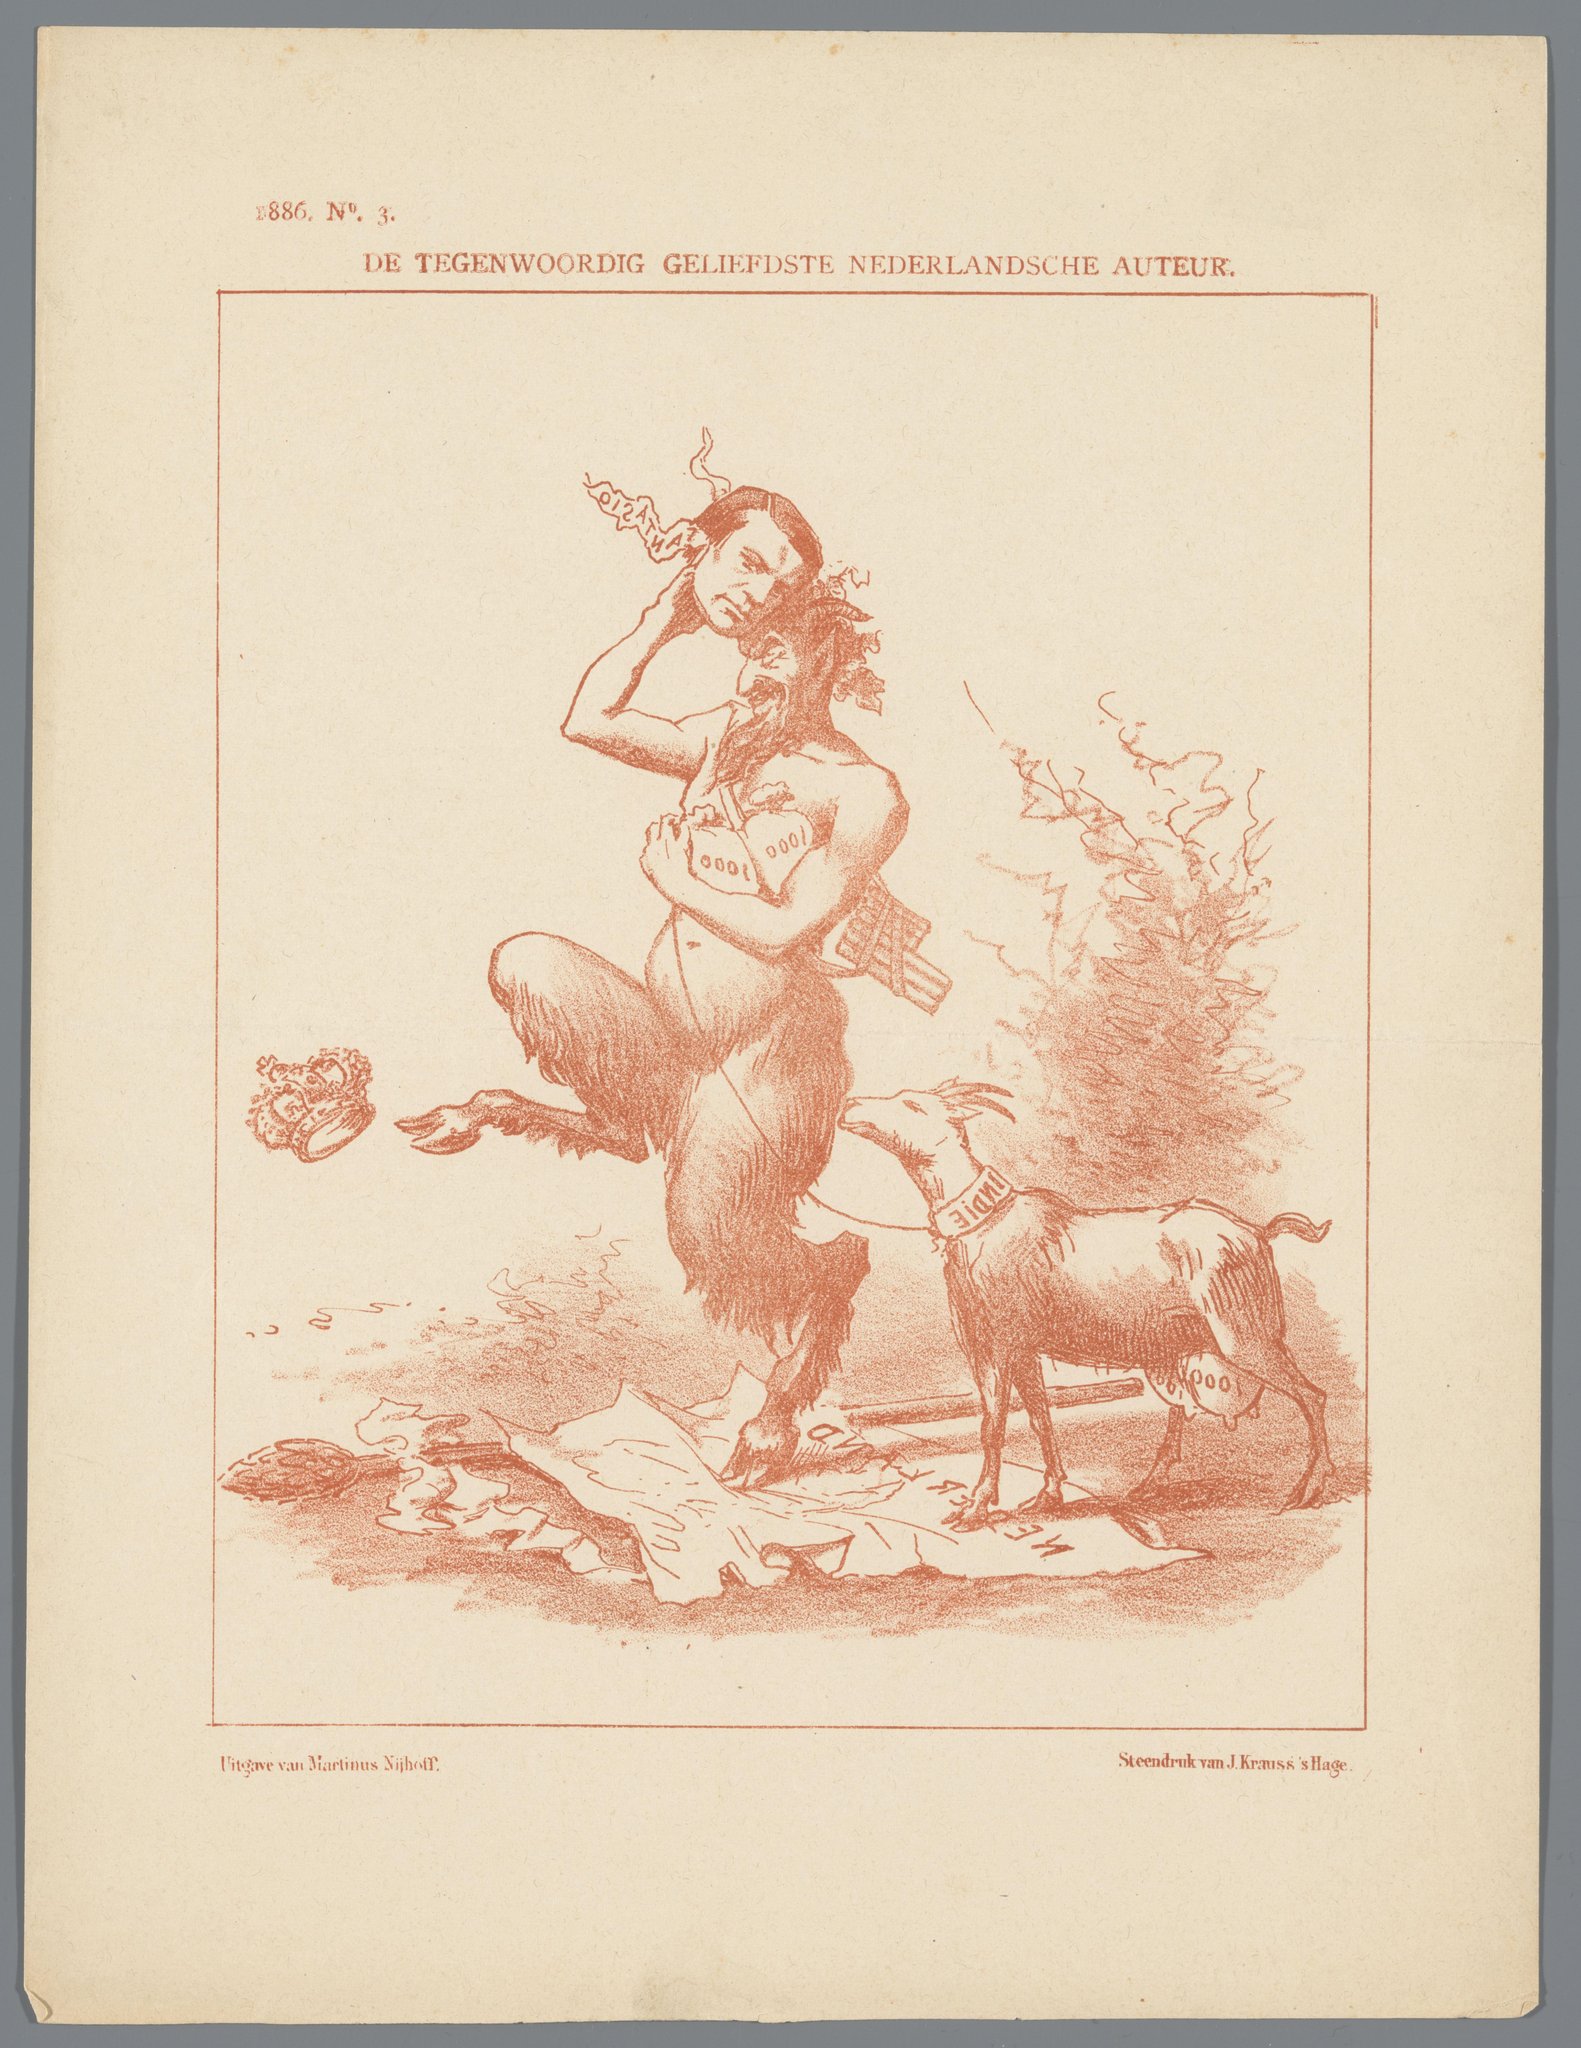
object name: cartoon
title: Spotprent op Busken Huet, 1886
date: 1886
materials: paper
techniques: lithograph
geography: the hague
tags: paris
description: Spotprent met een sater met een masker met gezicht van de auteur Conrad Busken Huet. Plaat verschenen bij het weekblad De Nederlandsche Spectator, nr. 3, 1886.